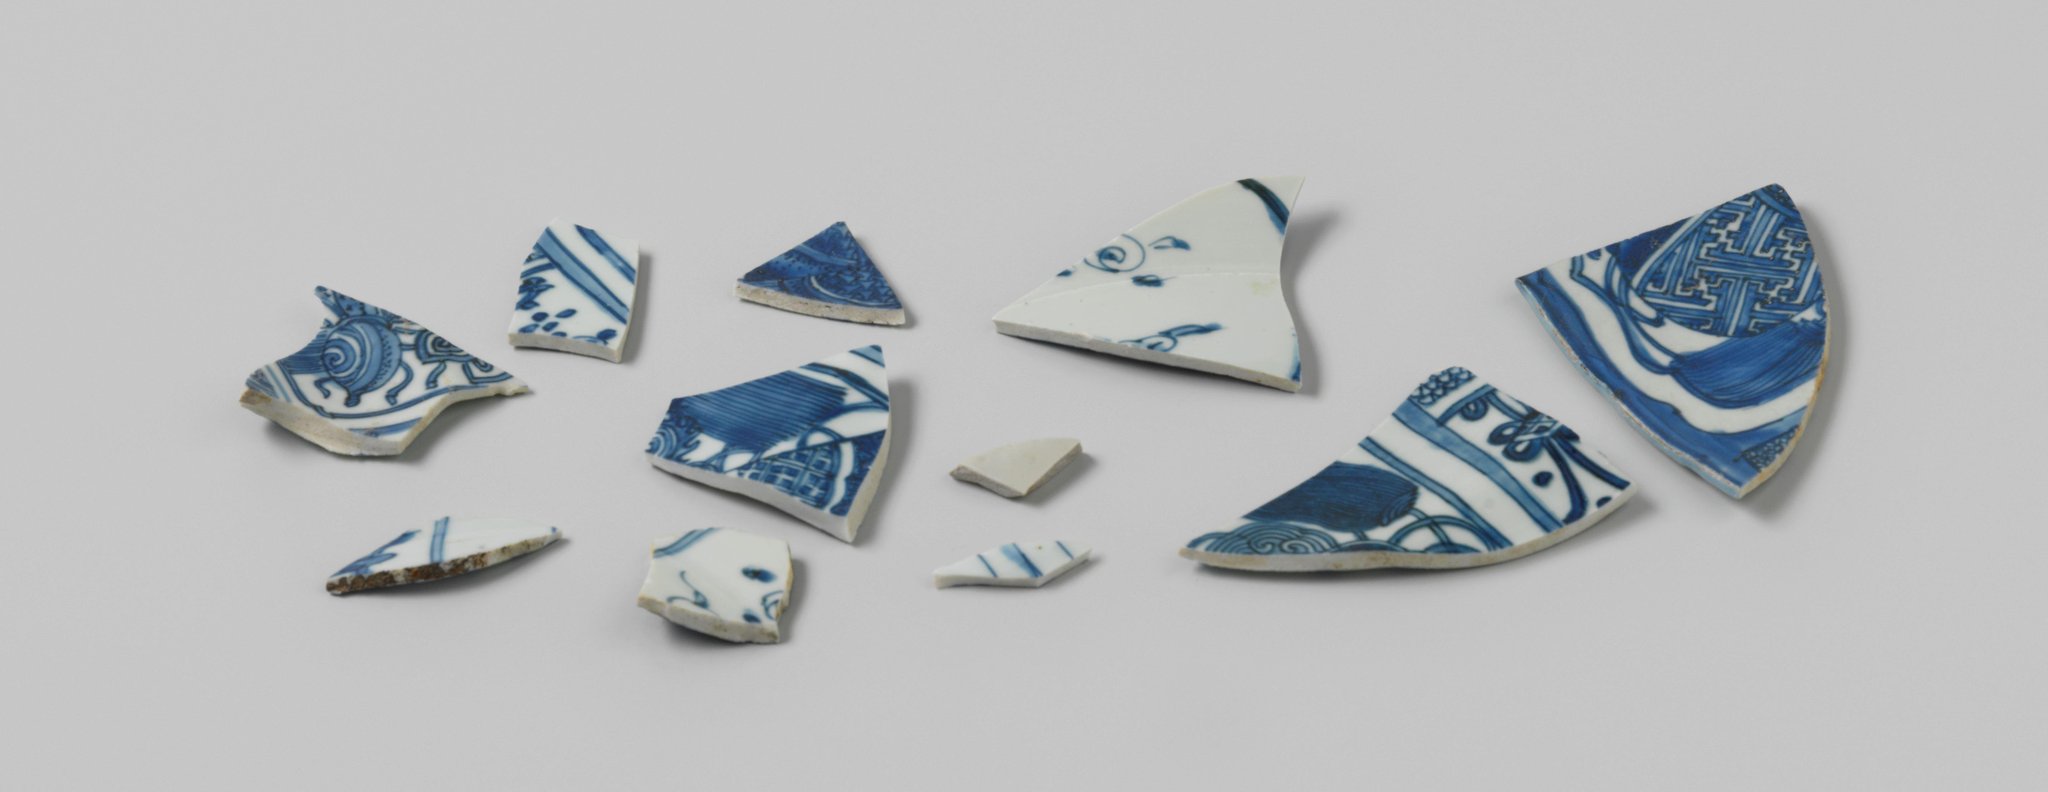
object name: sherd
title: Scherven van borden uit V.O.C.-schip de 'Witte Leeuw'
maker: Anonymous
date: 1613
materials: bone china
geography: jingdezhen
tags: verenigde oostindische compagnie, sint-helena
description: Scherven van borden uit V.O.C.-schip de 'Witte Leeuw'.